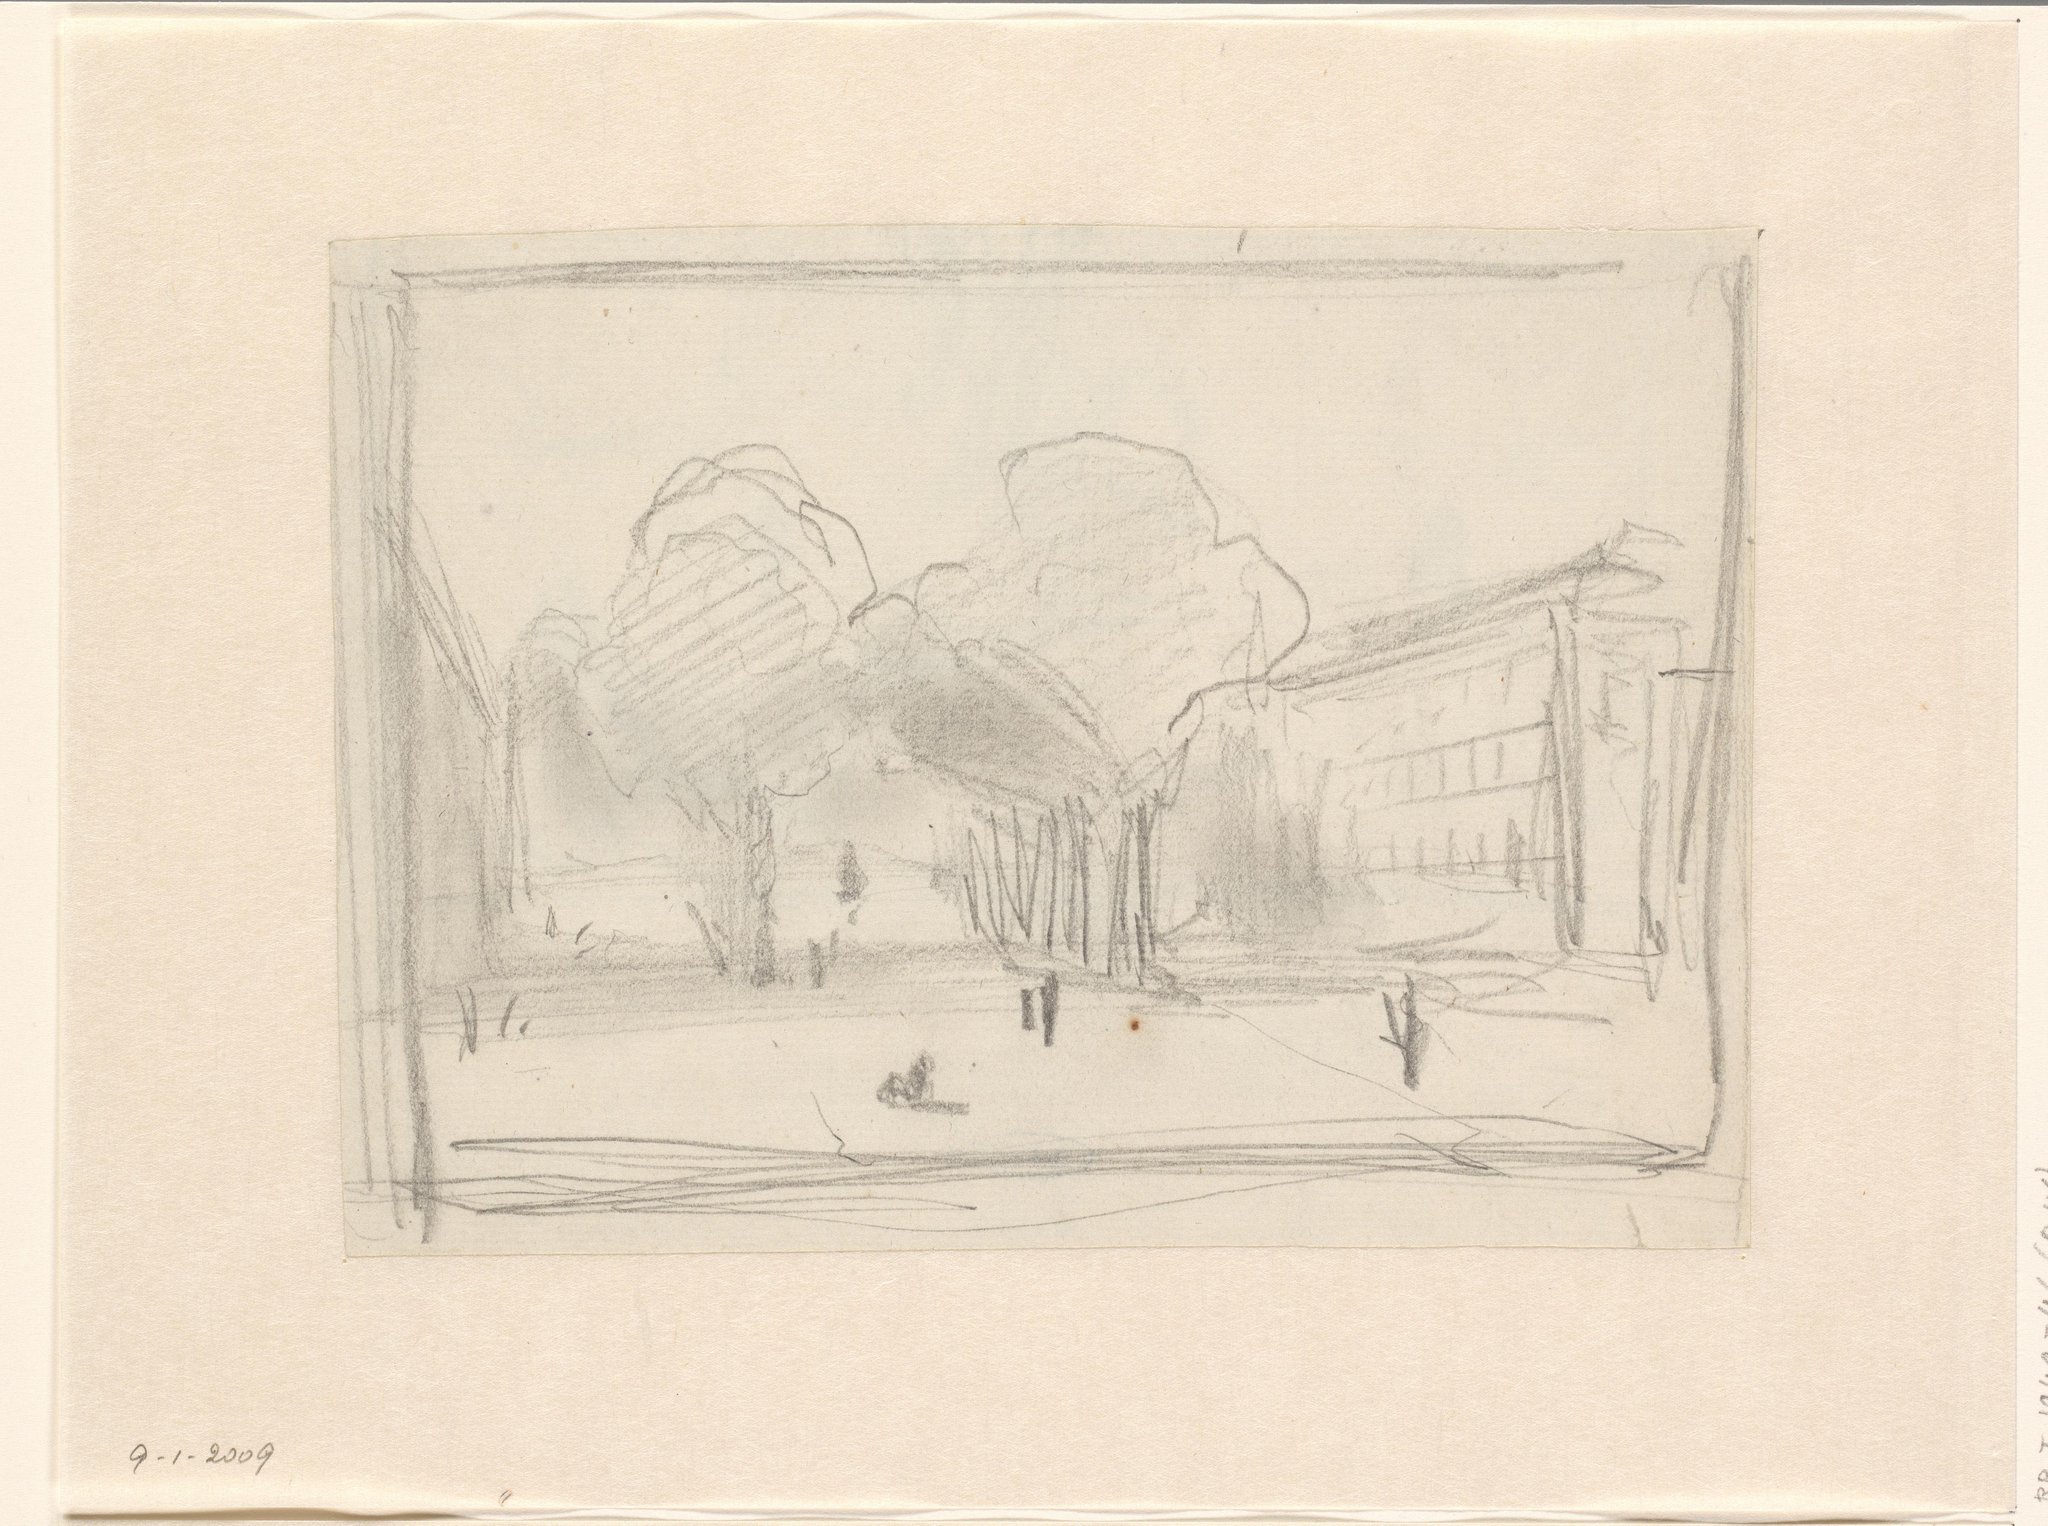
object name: drawing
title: Schets van een allee in een stad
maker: andreas schelfhout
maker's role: draughtsman, painter, print maker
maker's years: 1787-1870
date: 1797-1870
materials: paper, pencil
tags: avenue, boulevard, promenade, esplanade